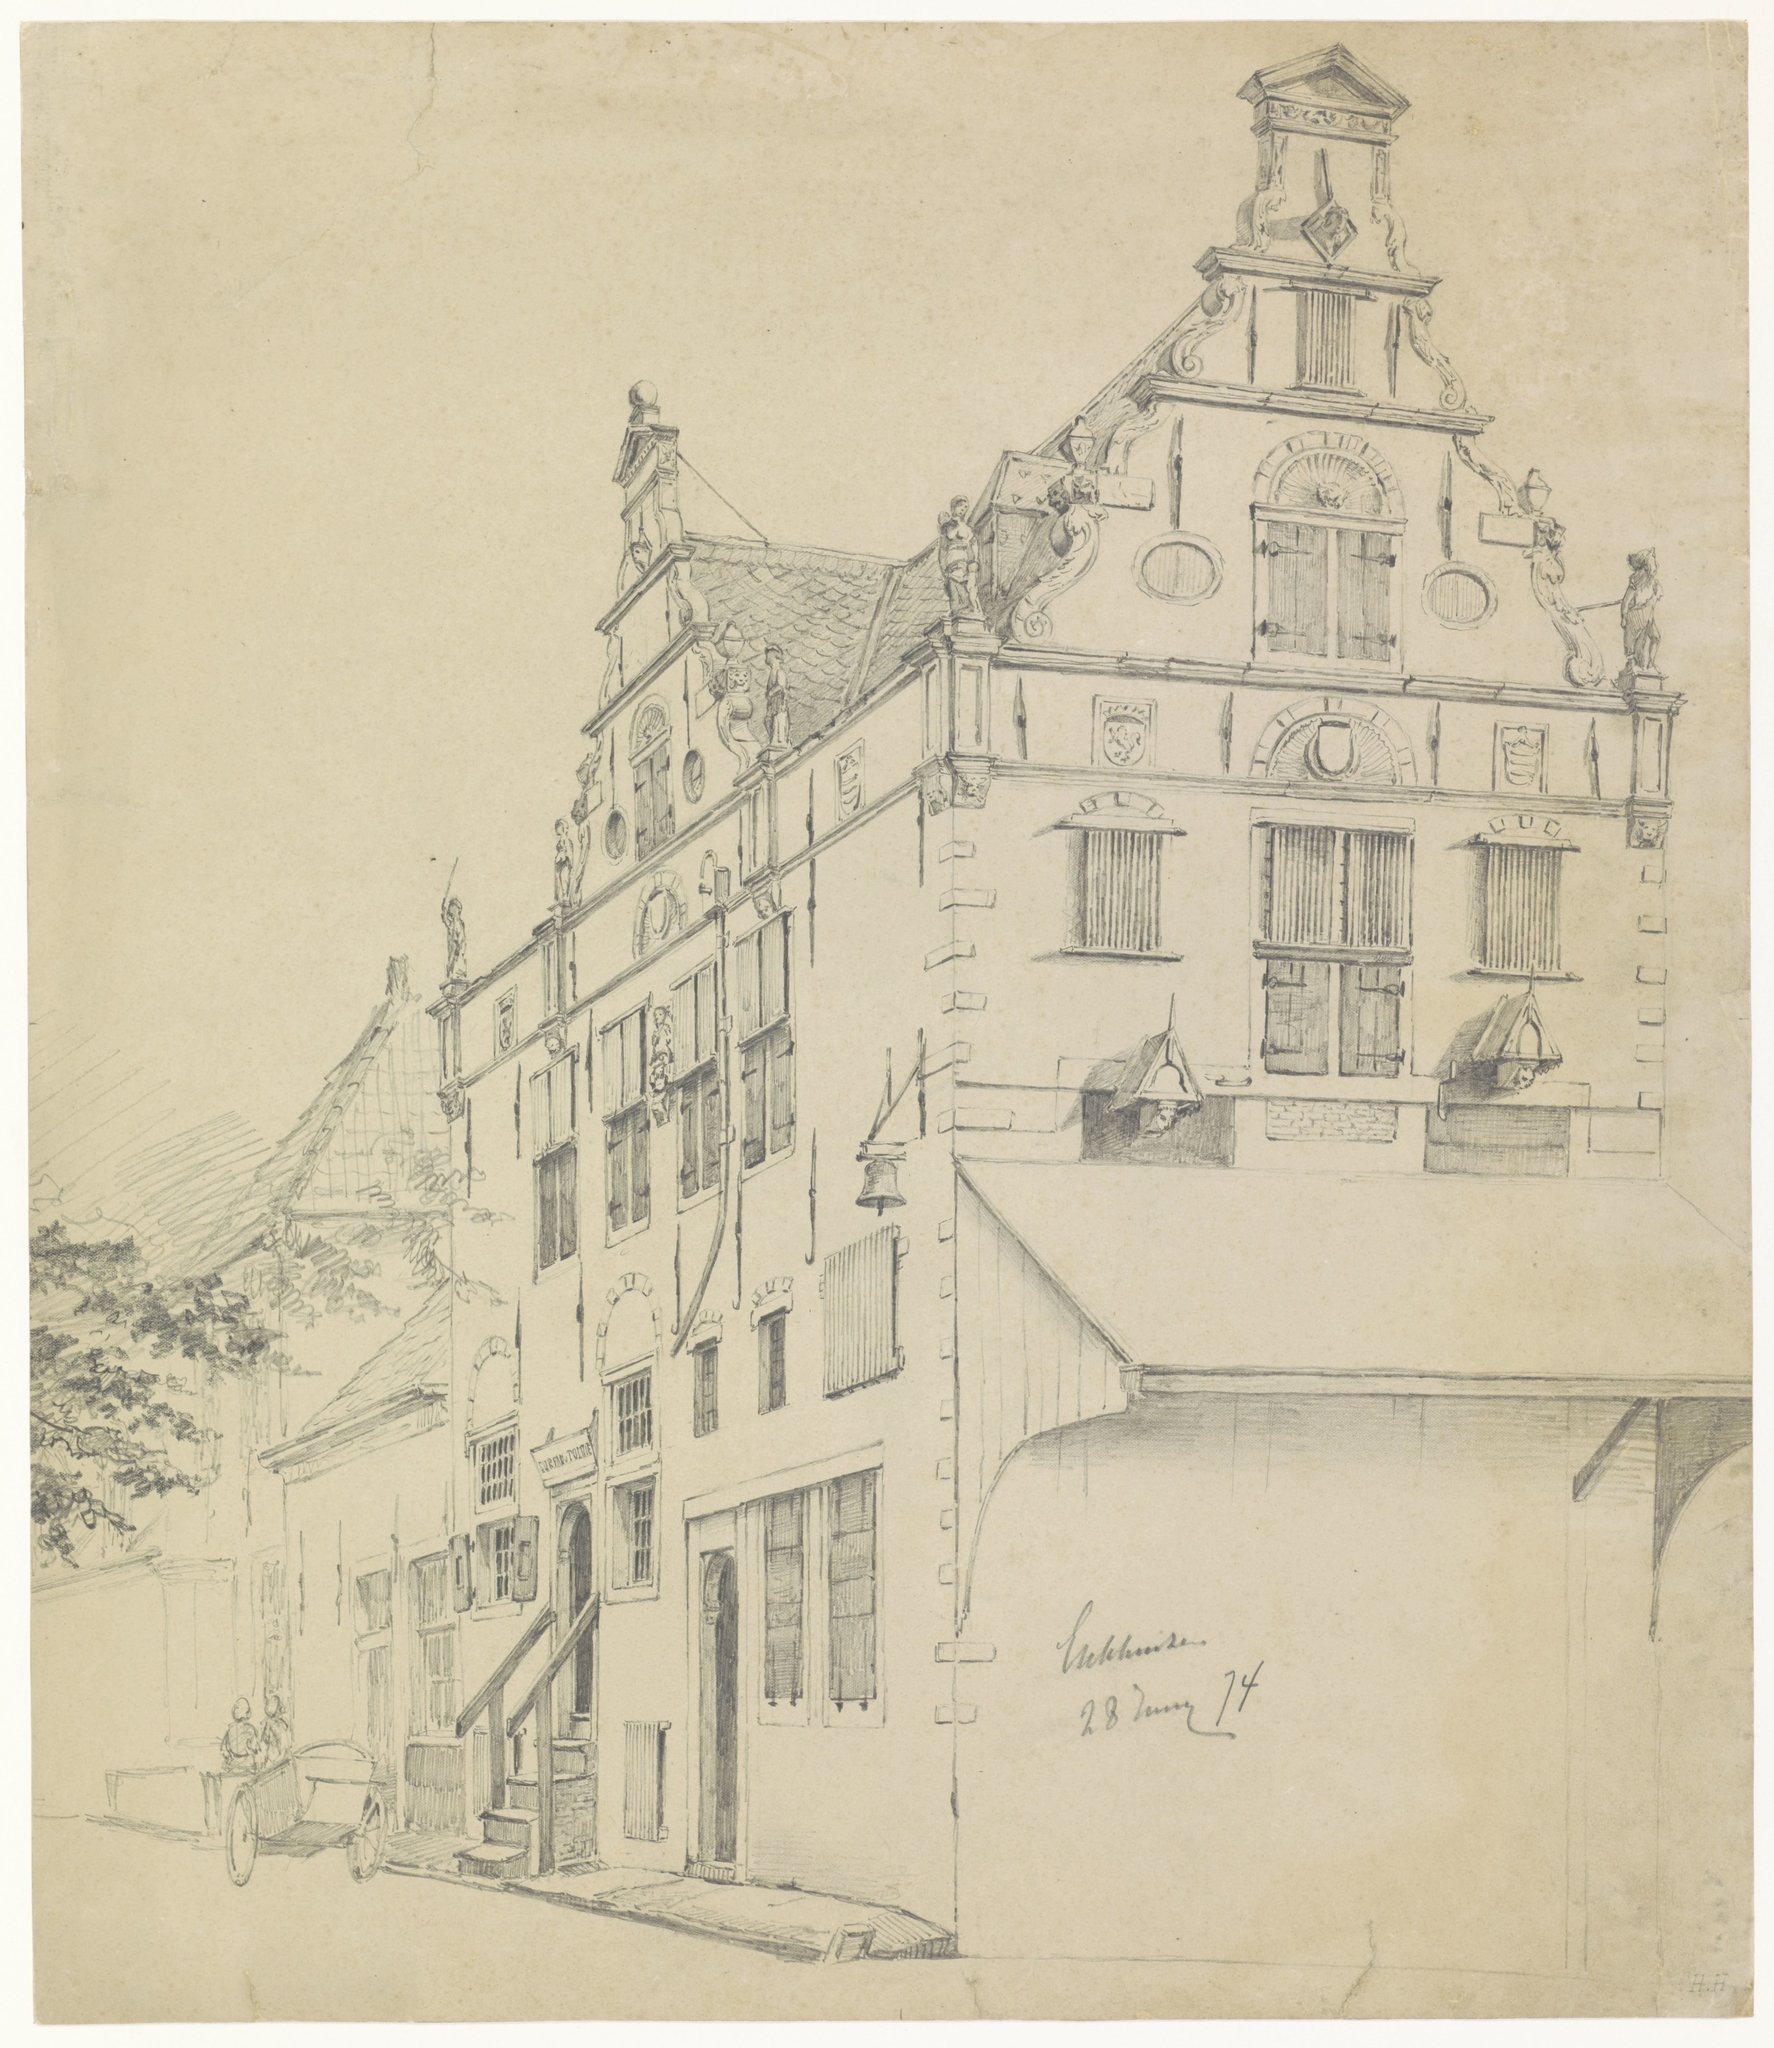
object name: drawing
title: De Waag in Enkhuizen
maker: willem de haas hemken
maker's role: draughtsman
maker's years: 1831-1911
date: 1874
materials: paper, pencil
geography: enkhuizen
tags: waag (enkhuizen)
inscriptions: monogram: ‘HH’, annotation: ‘Enkhuizen’, date: ‘28 Juny 74’